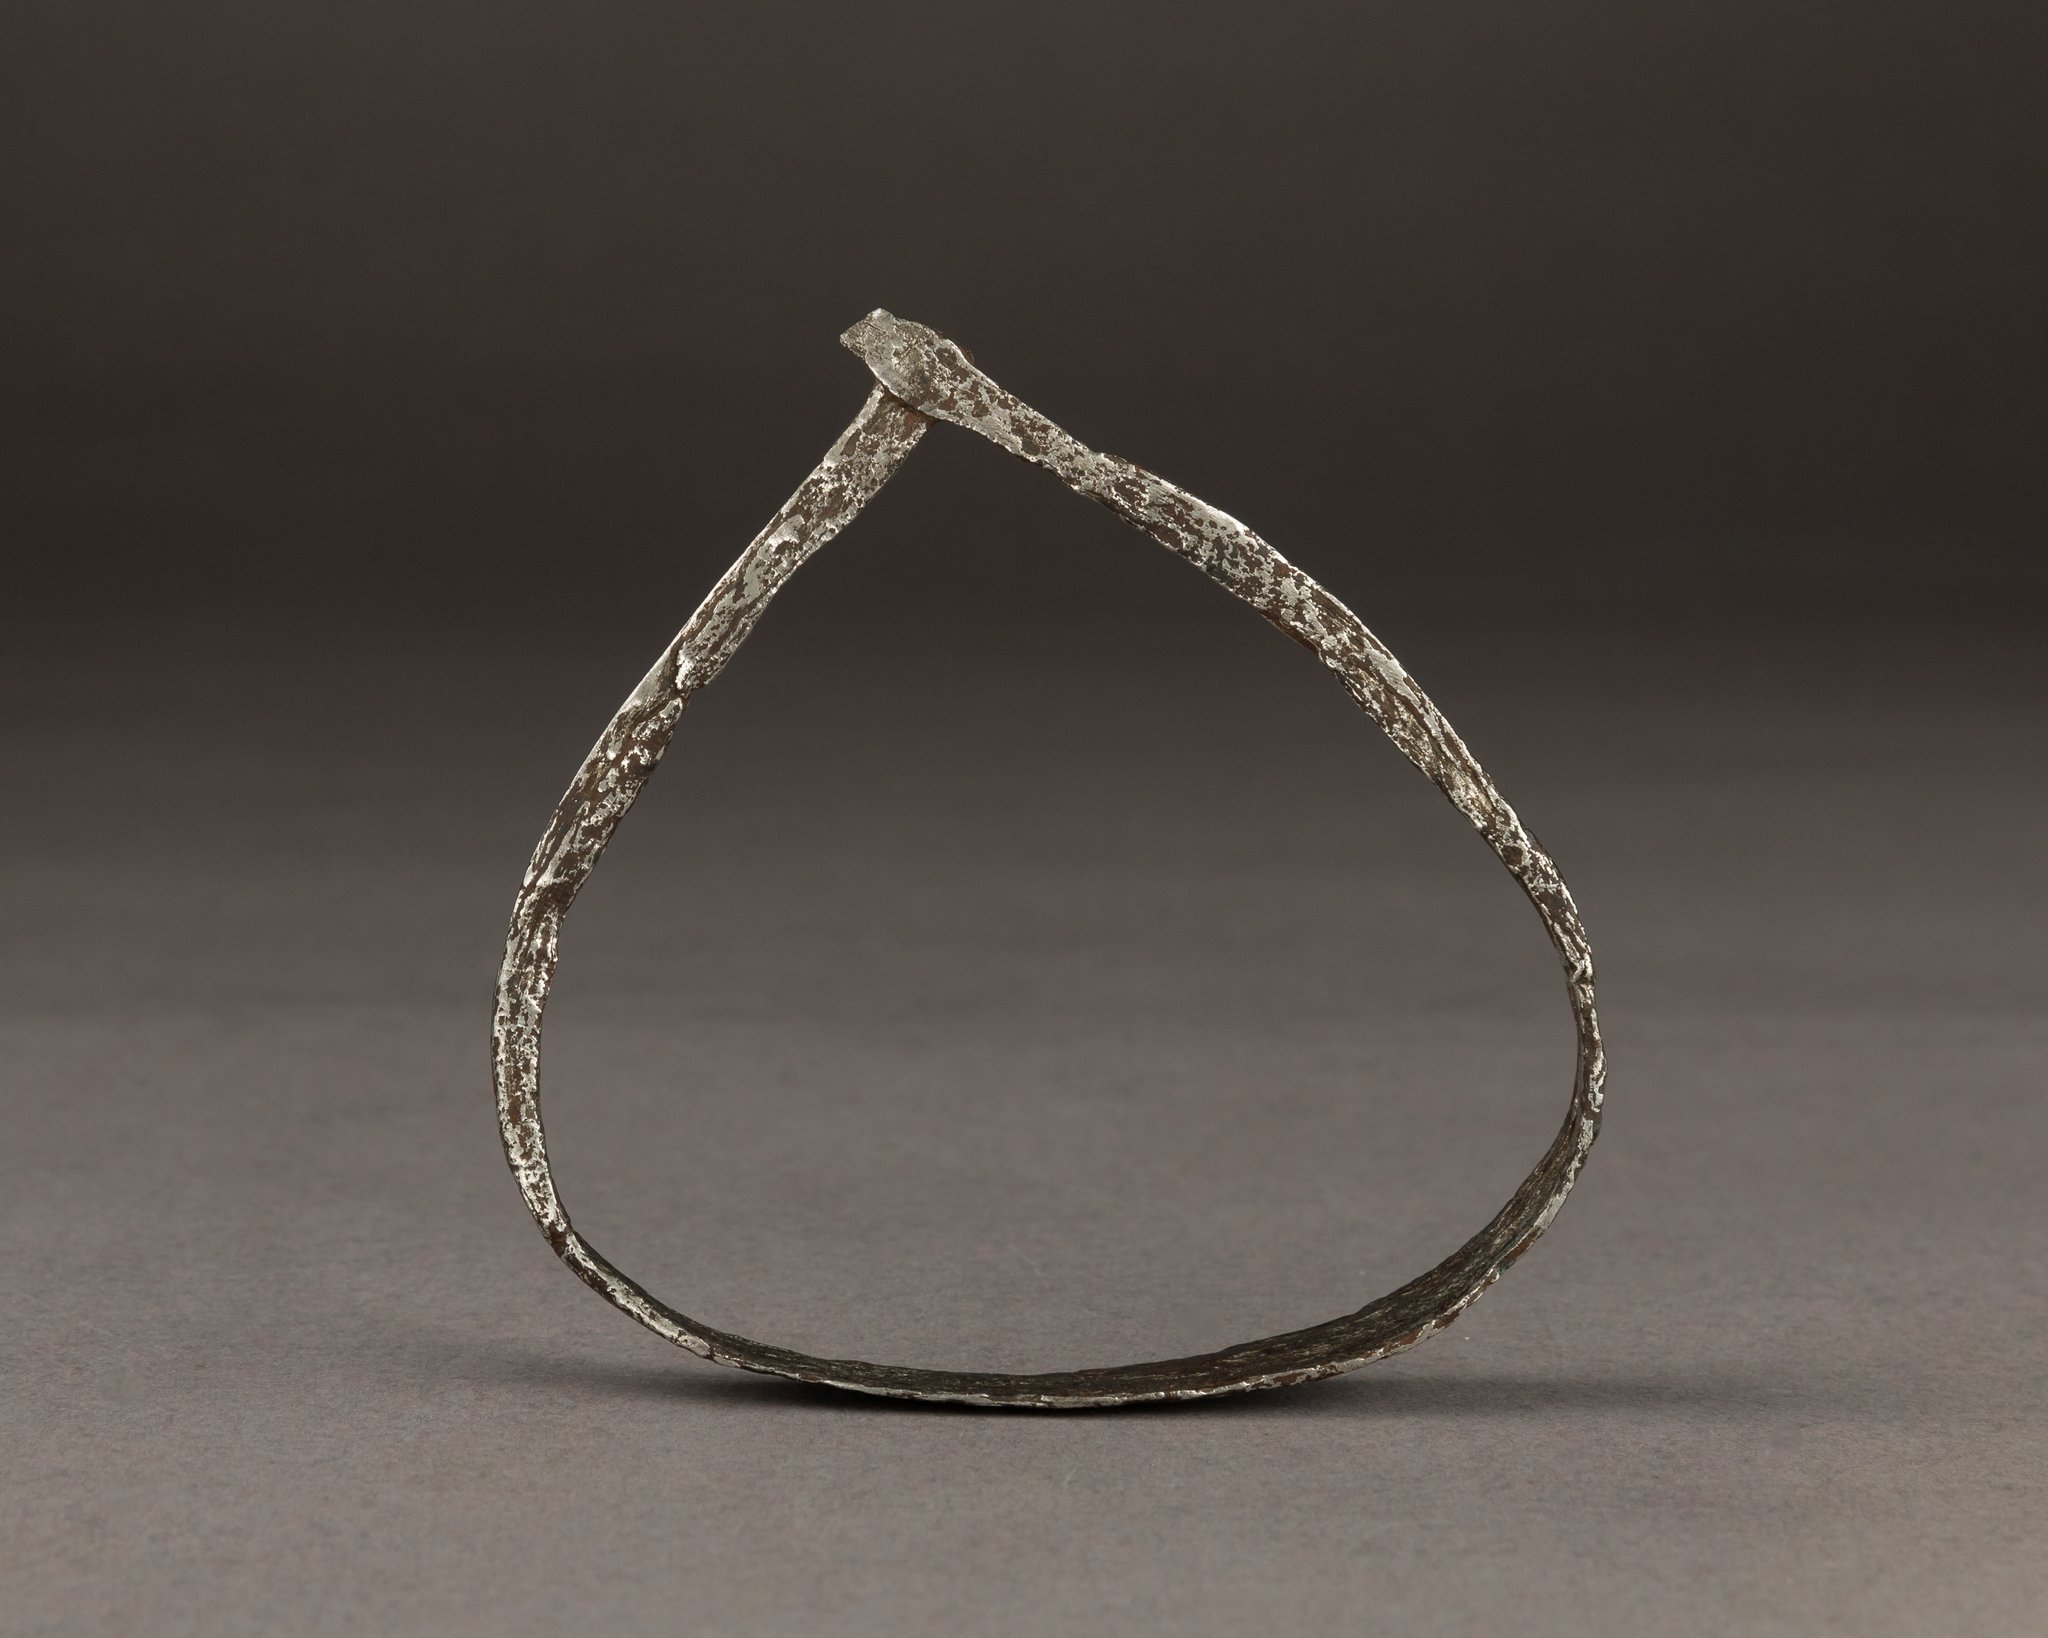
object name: stirrup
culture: west slavic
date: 801-1000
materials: iron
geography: poland